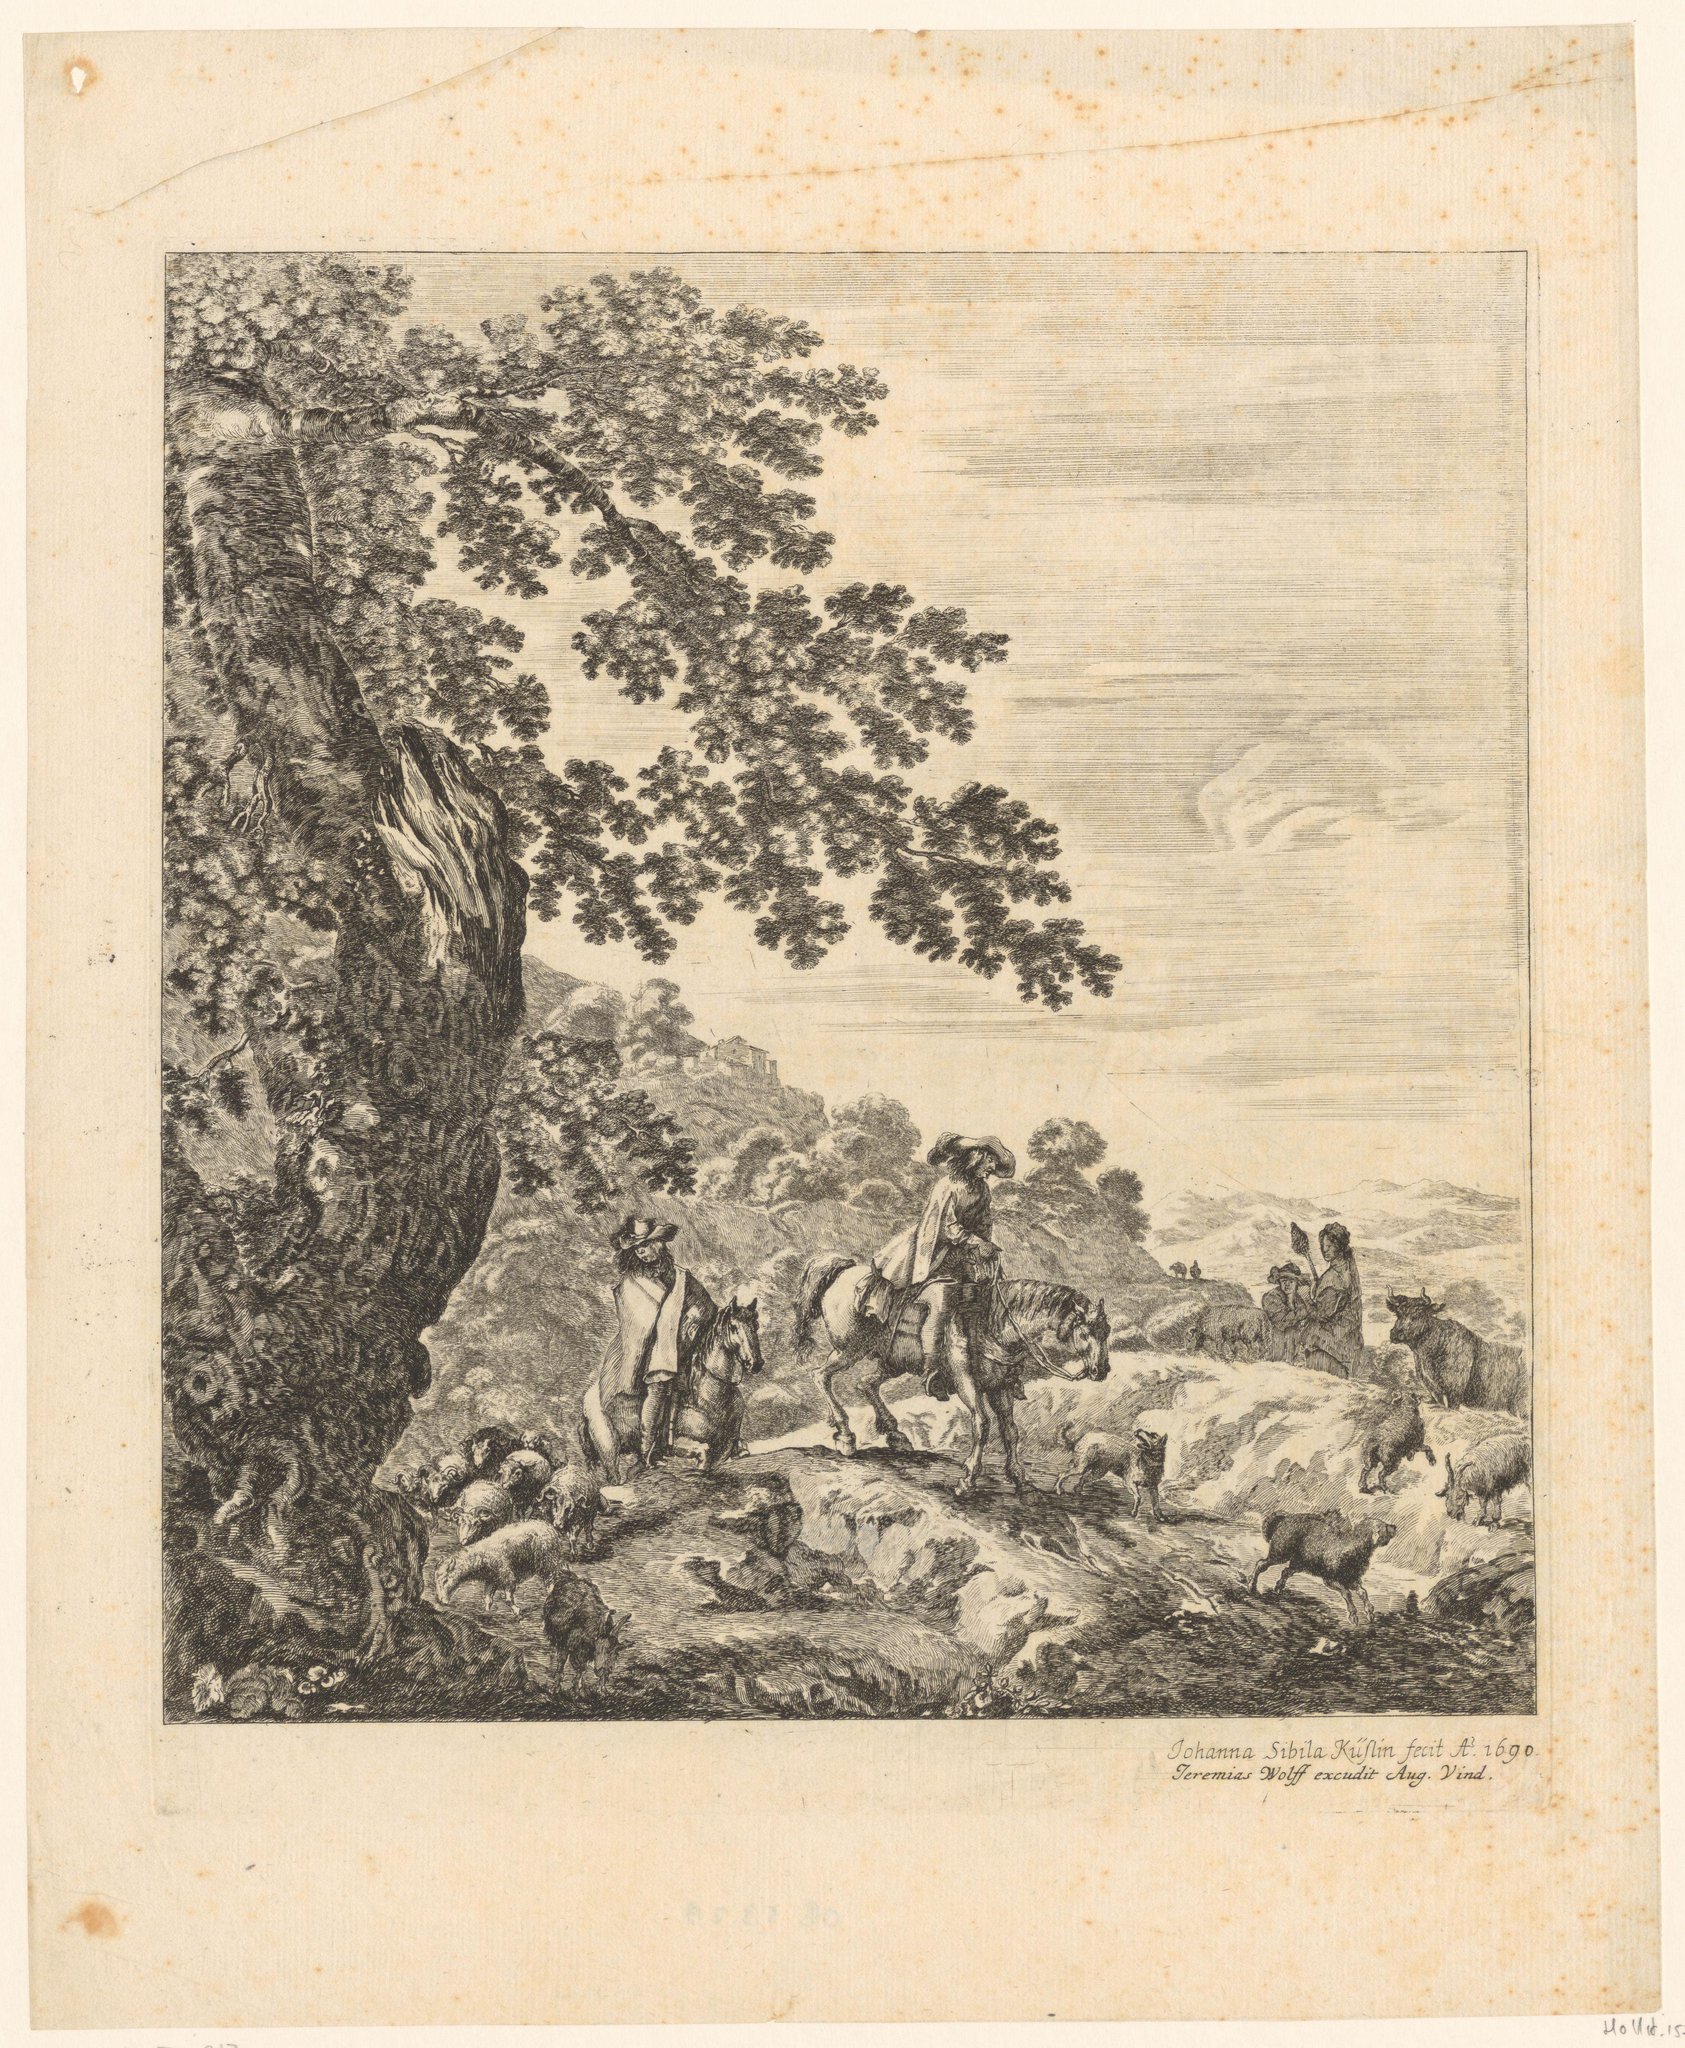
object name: print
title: Gezichten op Rome en Tivoli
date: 1690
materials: paper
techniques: etching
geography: augsburg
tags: low hill country, herding, herdsman, herdswoman, shepherd, shepherdess, cowherd, etc., 'en route', traveller under way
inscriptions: collector's mark: Lugt 2228, collector's mark: Lugt 240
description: Deze prent hoort bij een serie met twaalf prenten.